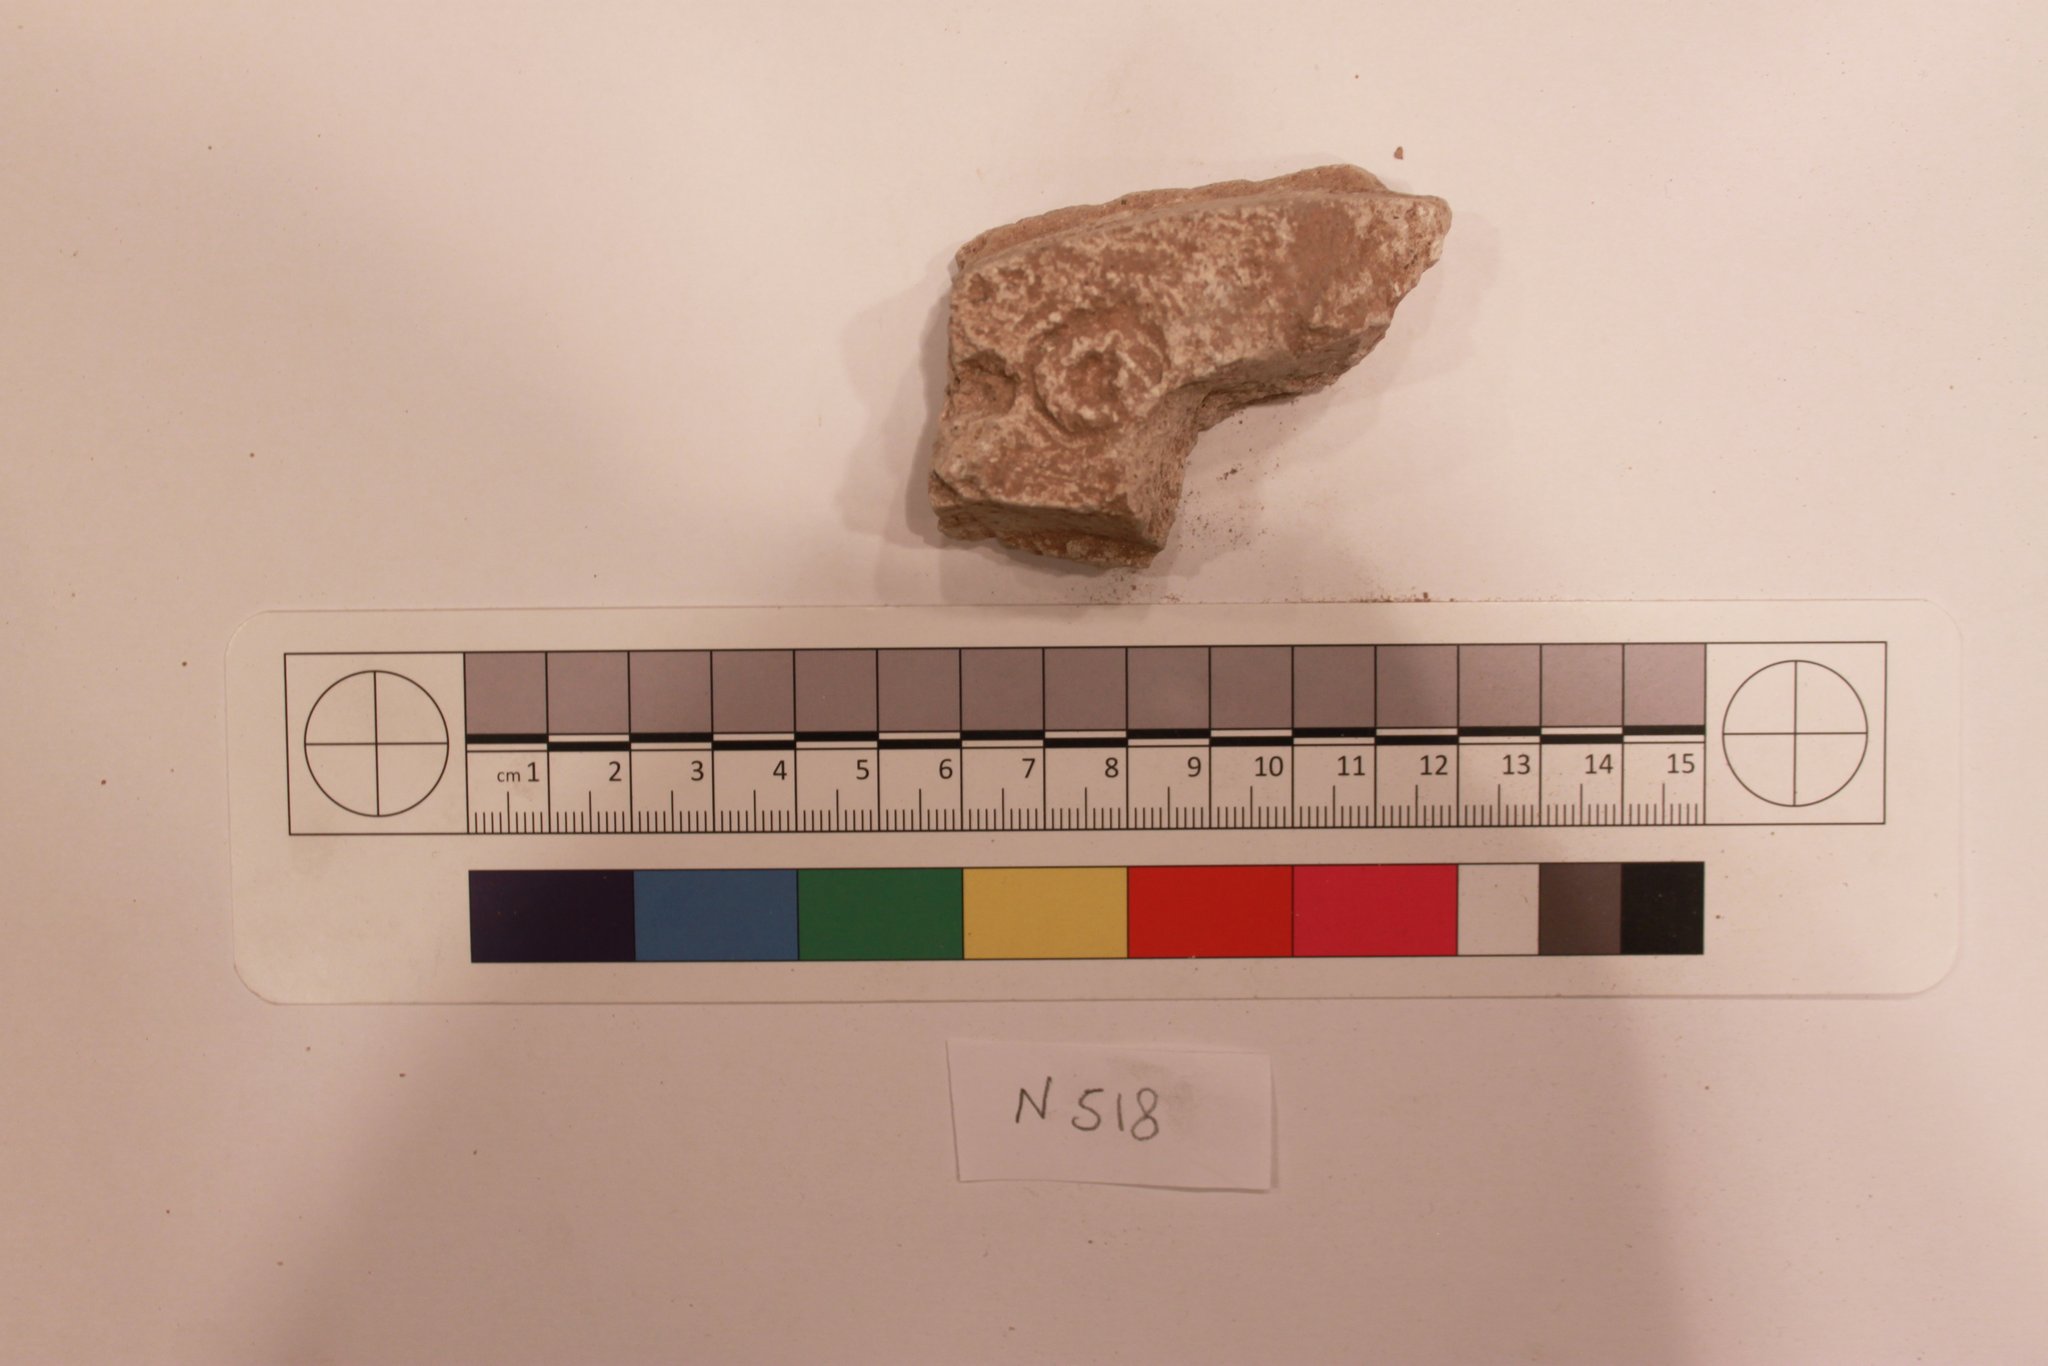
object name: fragment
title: Stucco Fragment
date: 701-1200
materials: plaster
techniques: carving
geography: iran